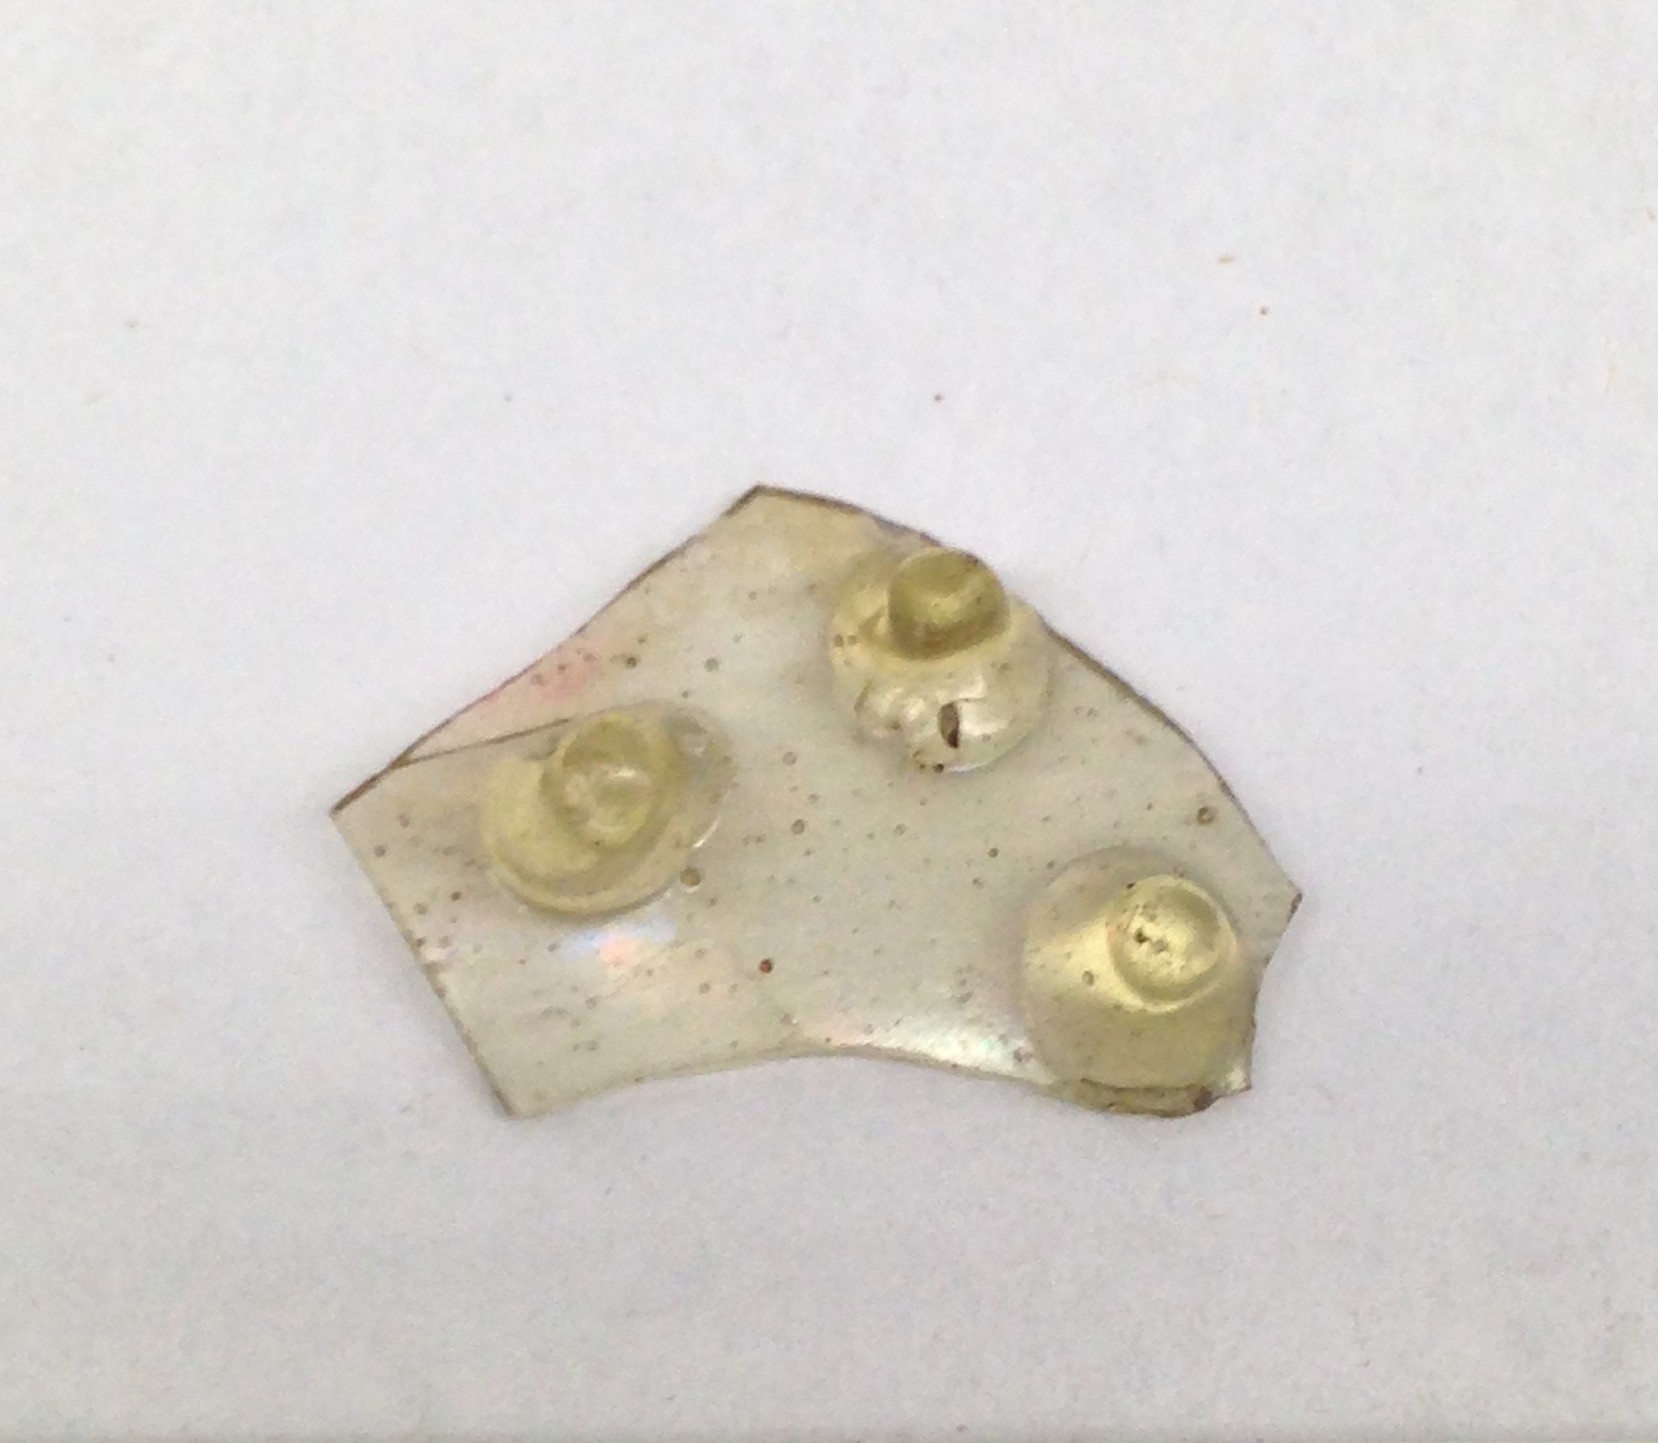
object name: glass fragment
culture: crusader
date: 1201-1300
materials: glass